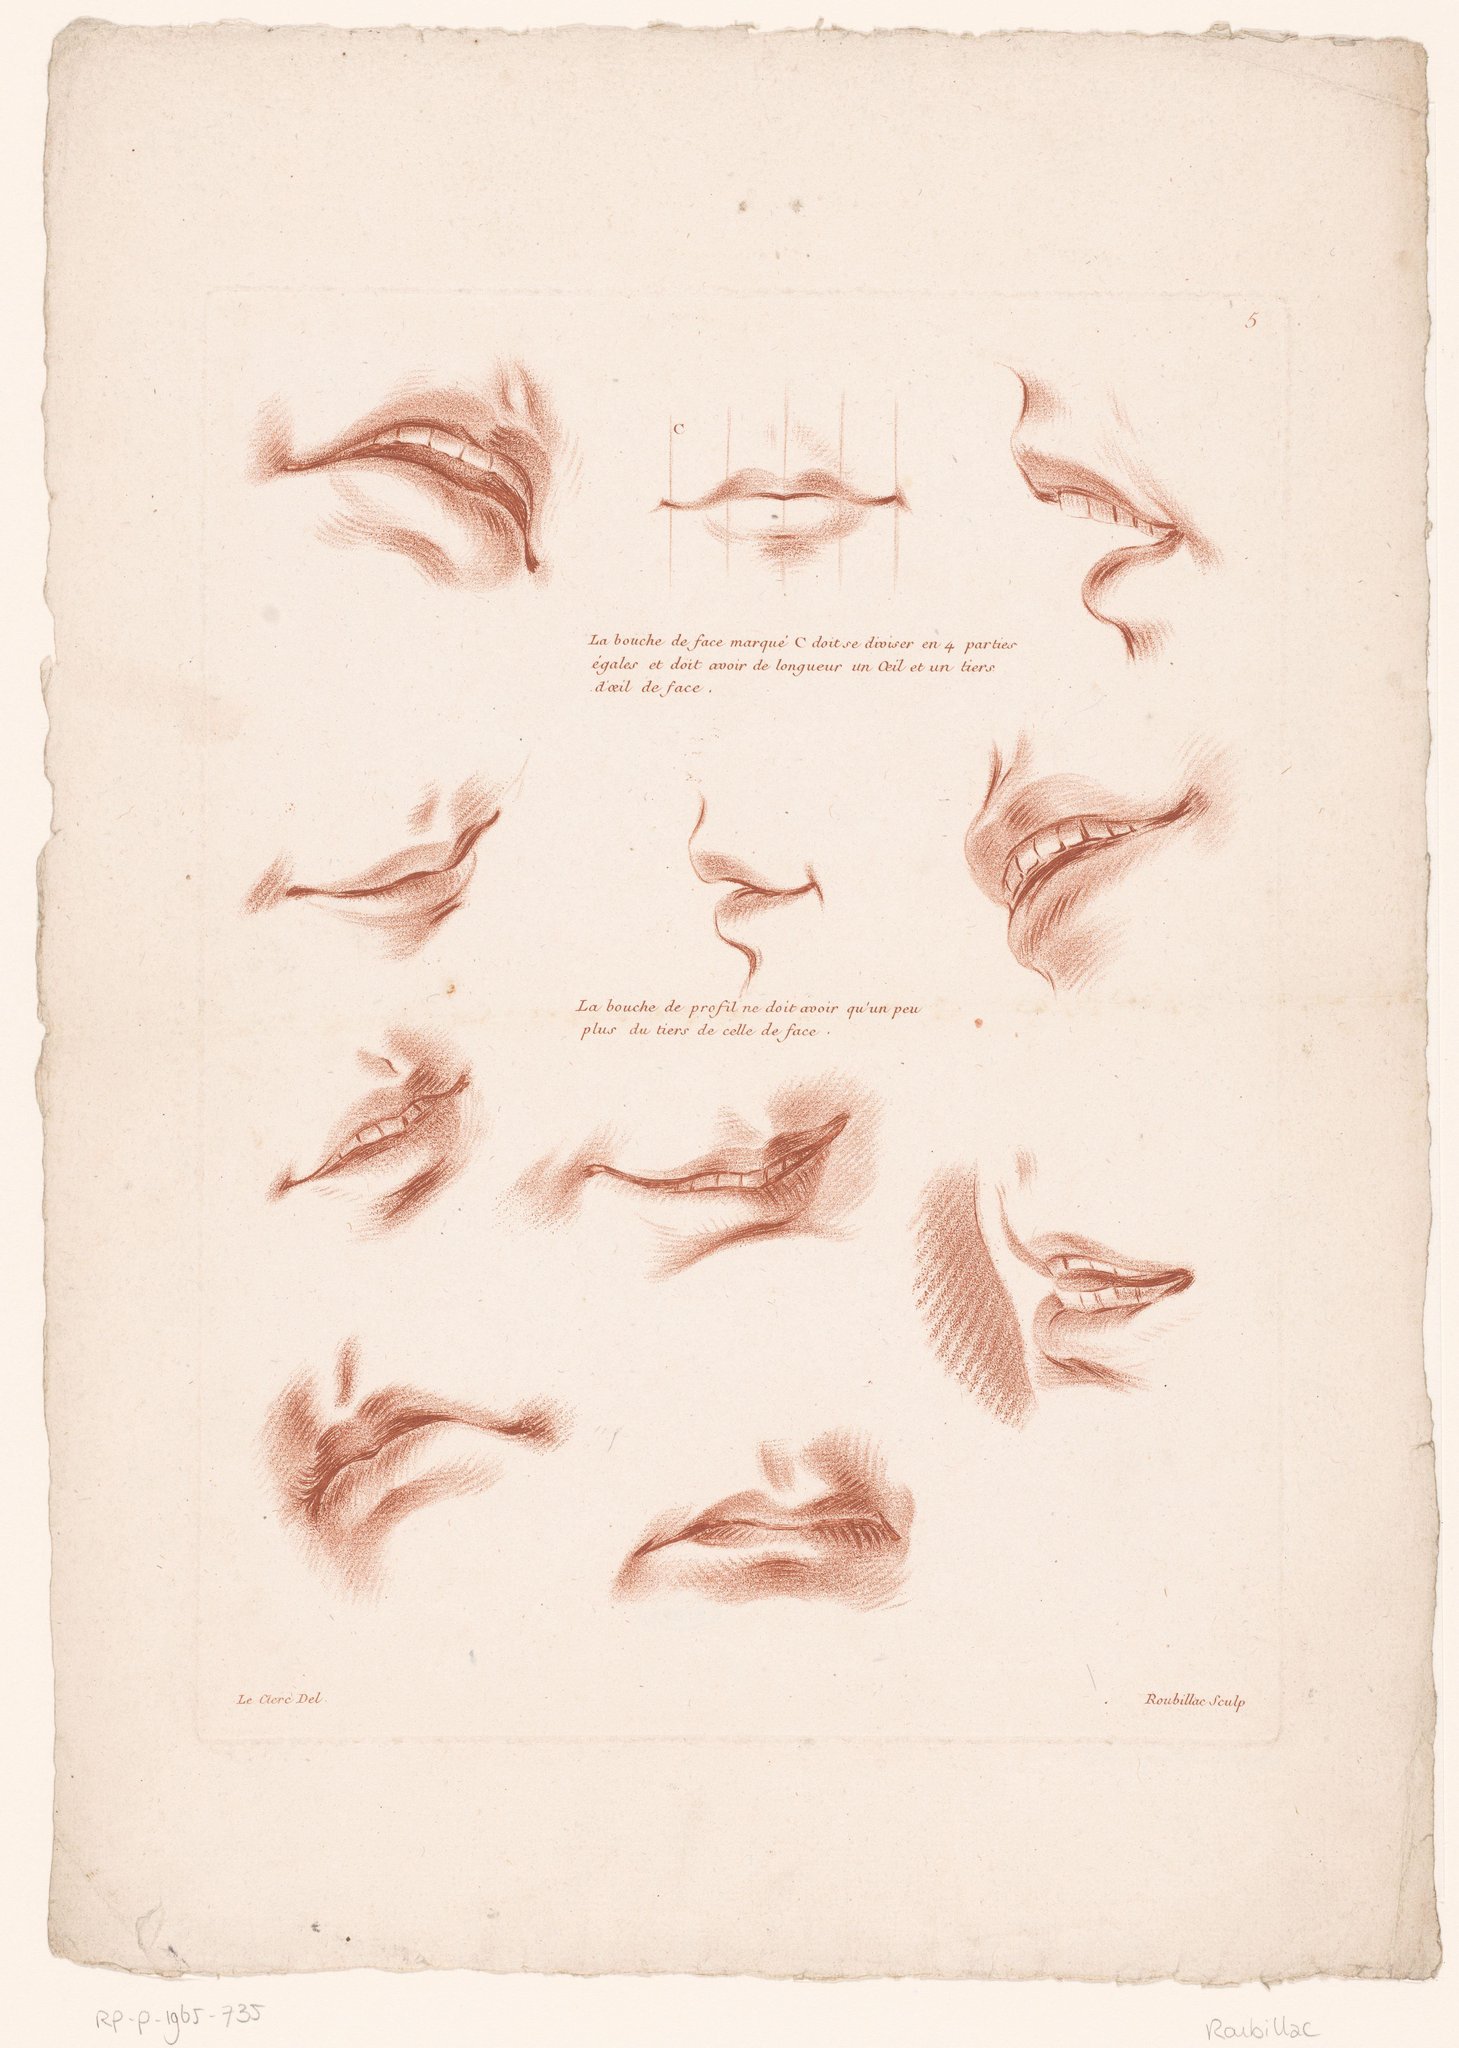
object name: print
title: Elf monden in verschillende uitdrukkingen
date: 1784-1796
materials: paper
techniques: printmaking, etching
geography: paris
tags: drawing, sketch, mouth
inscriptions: collector's mark: Lugt 2228